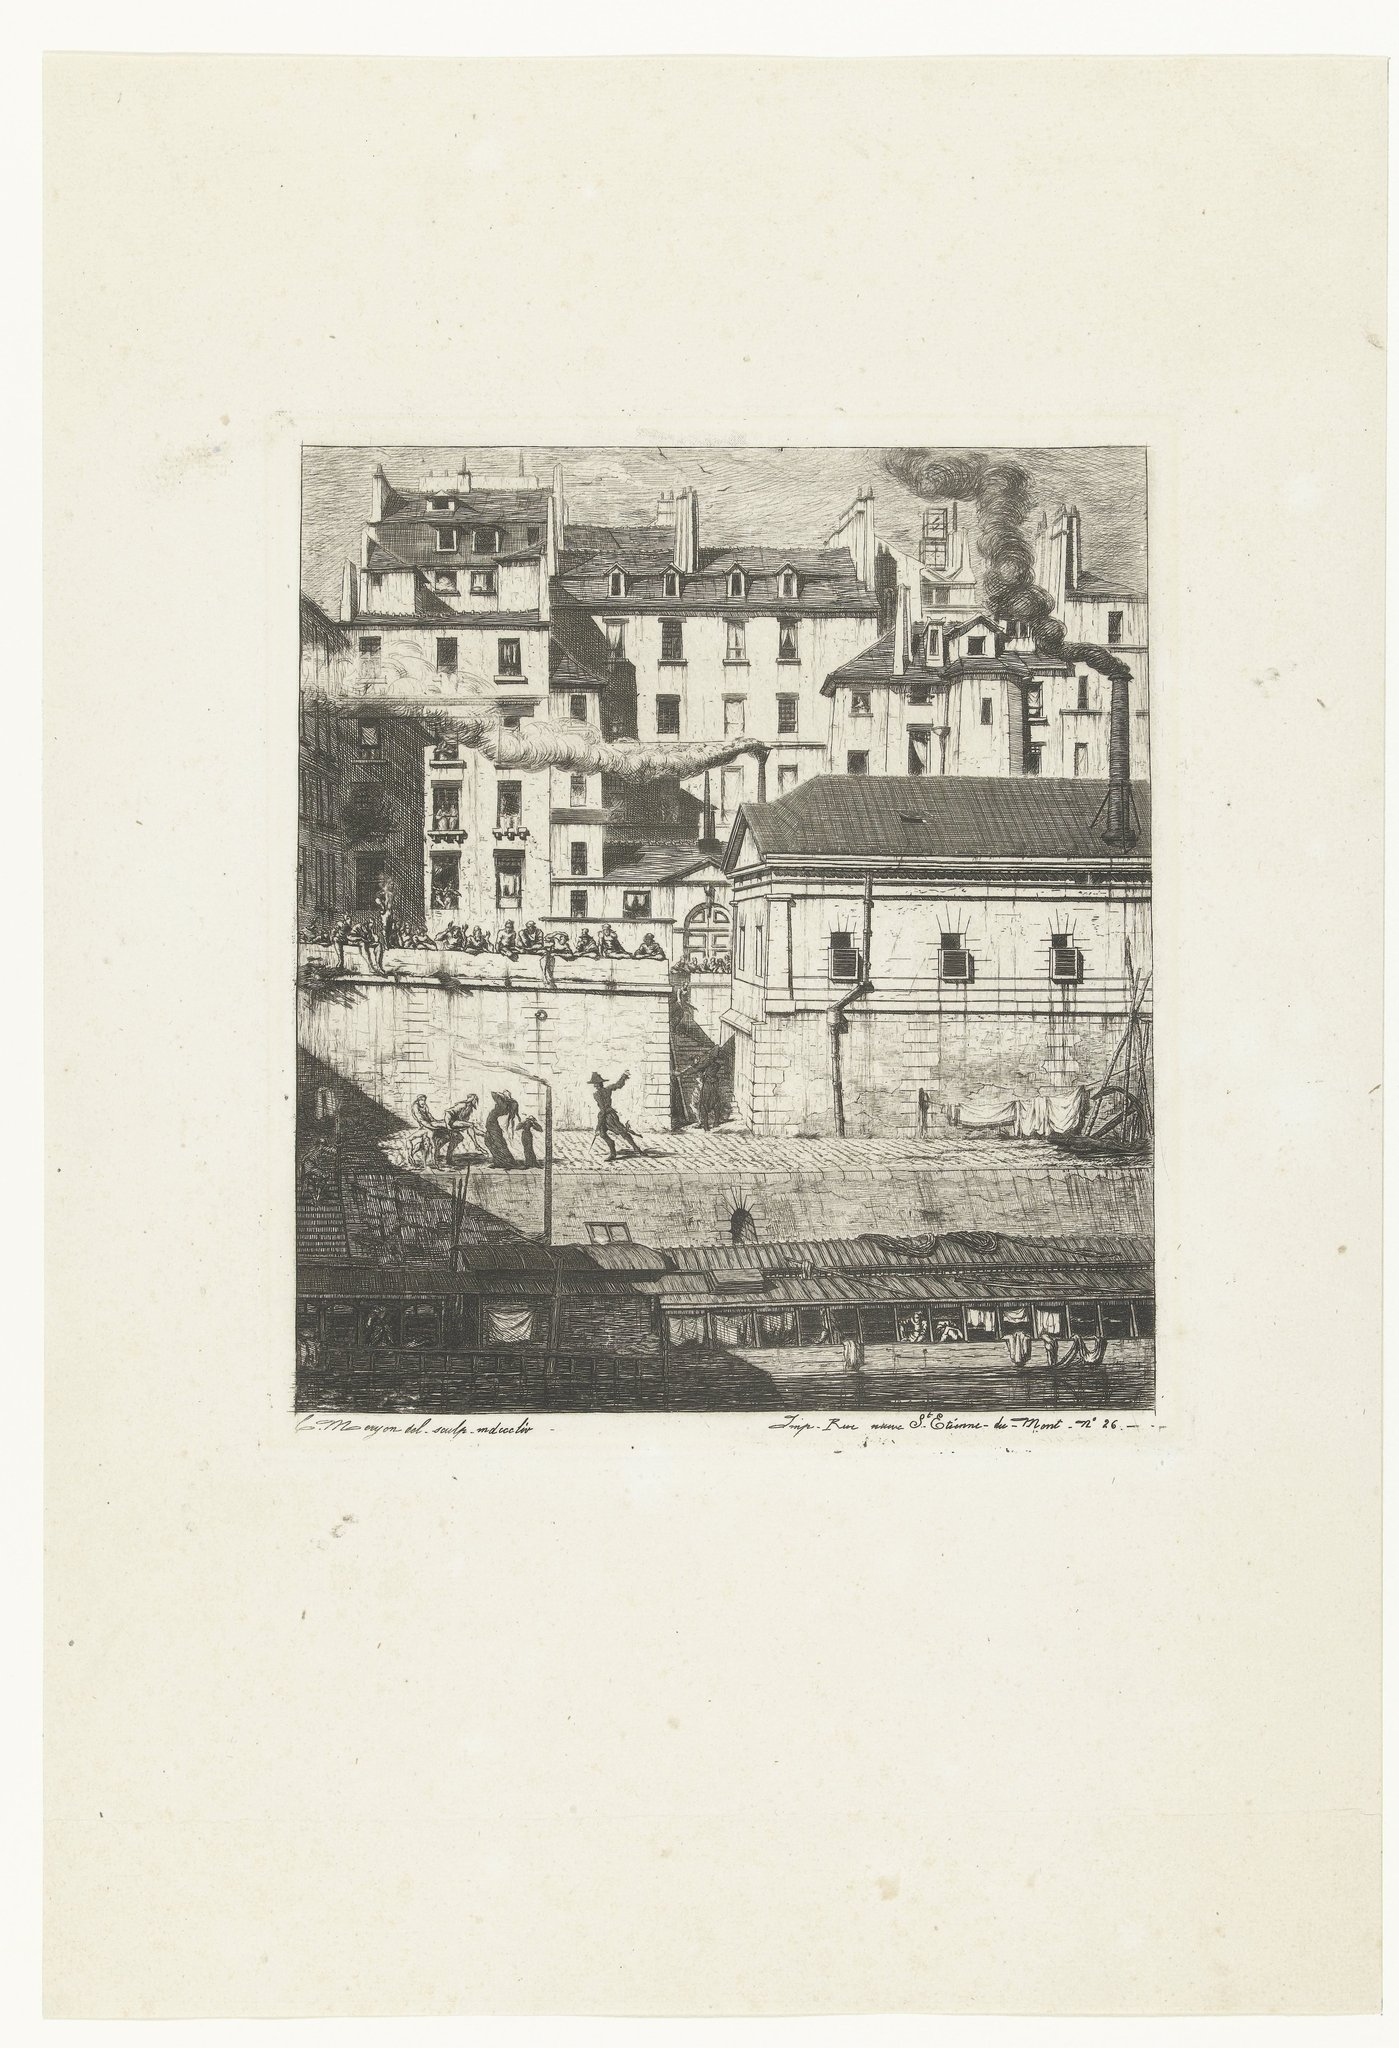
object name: print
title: La Morgue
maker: charles meryon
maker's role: print maker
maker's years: 1821-1868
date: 1854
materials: paper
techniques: drypoint, etching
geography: paris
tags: burial association, paris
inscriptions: collector's mark: Lugt 2228, collector's mark: Lugt 2760, collector's mark:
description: Het lijkenhuis of Morgue van Parijs staat met rokende schoorstenen op de kade van de Seine. Op de kade wordt een lijk richting het gebouw gedragen terwijl een vrouw en kind rouwen. De kademuur zit vol toeschouwers.